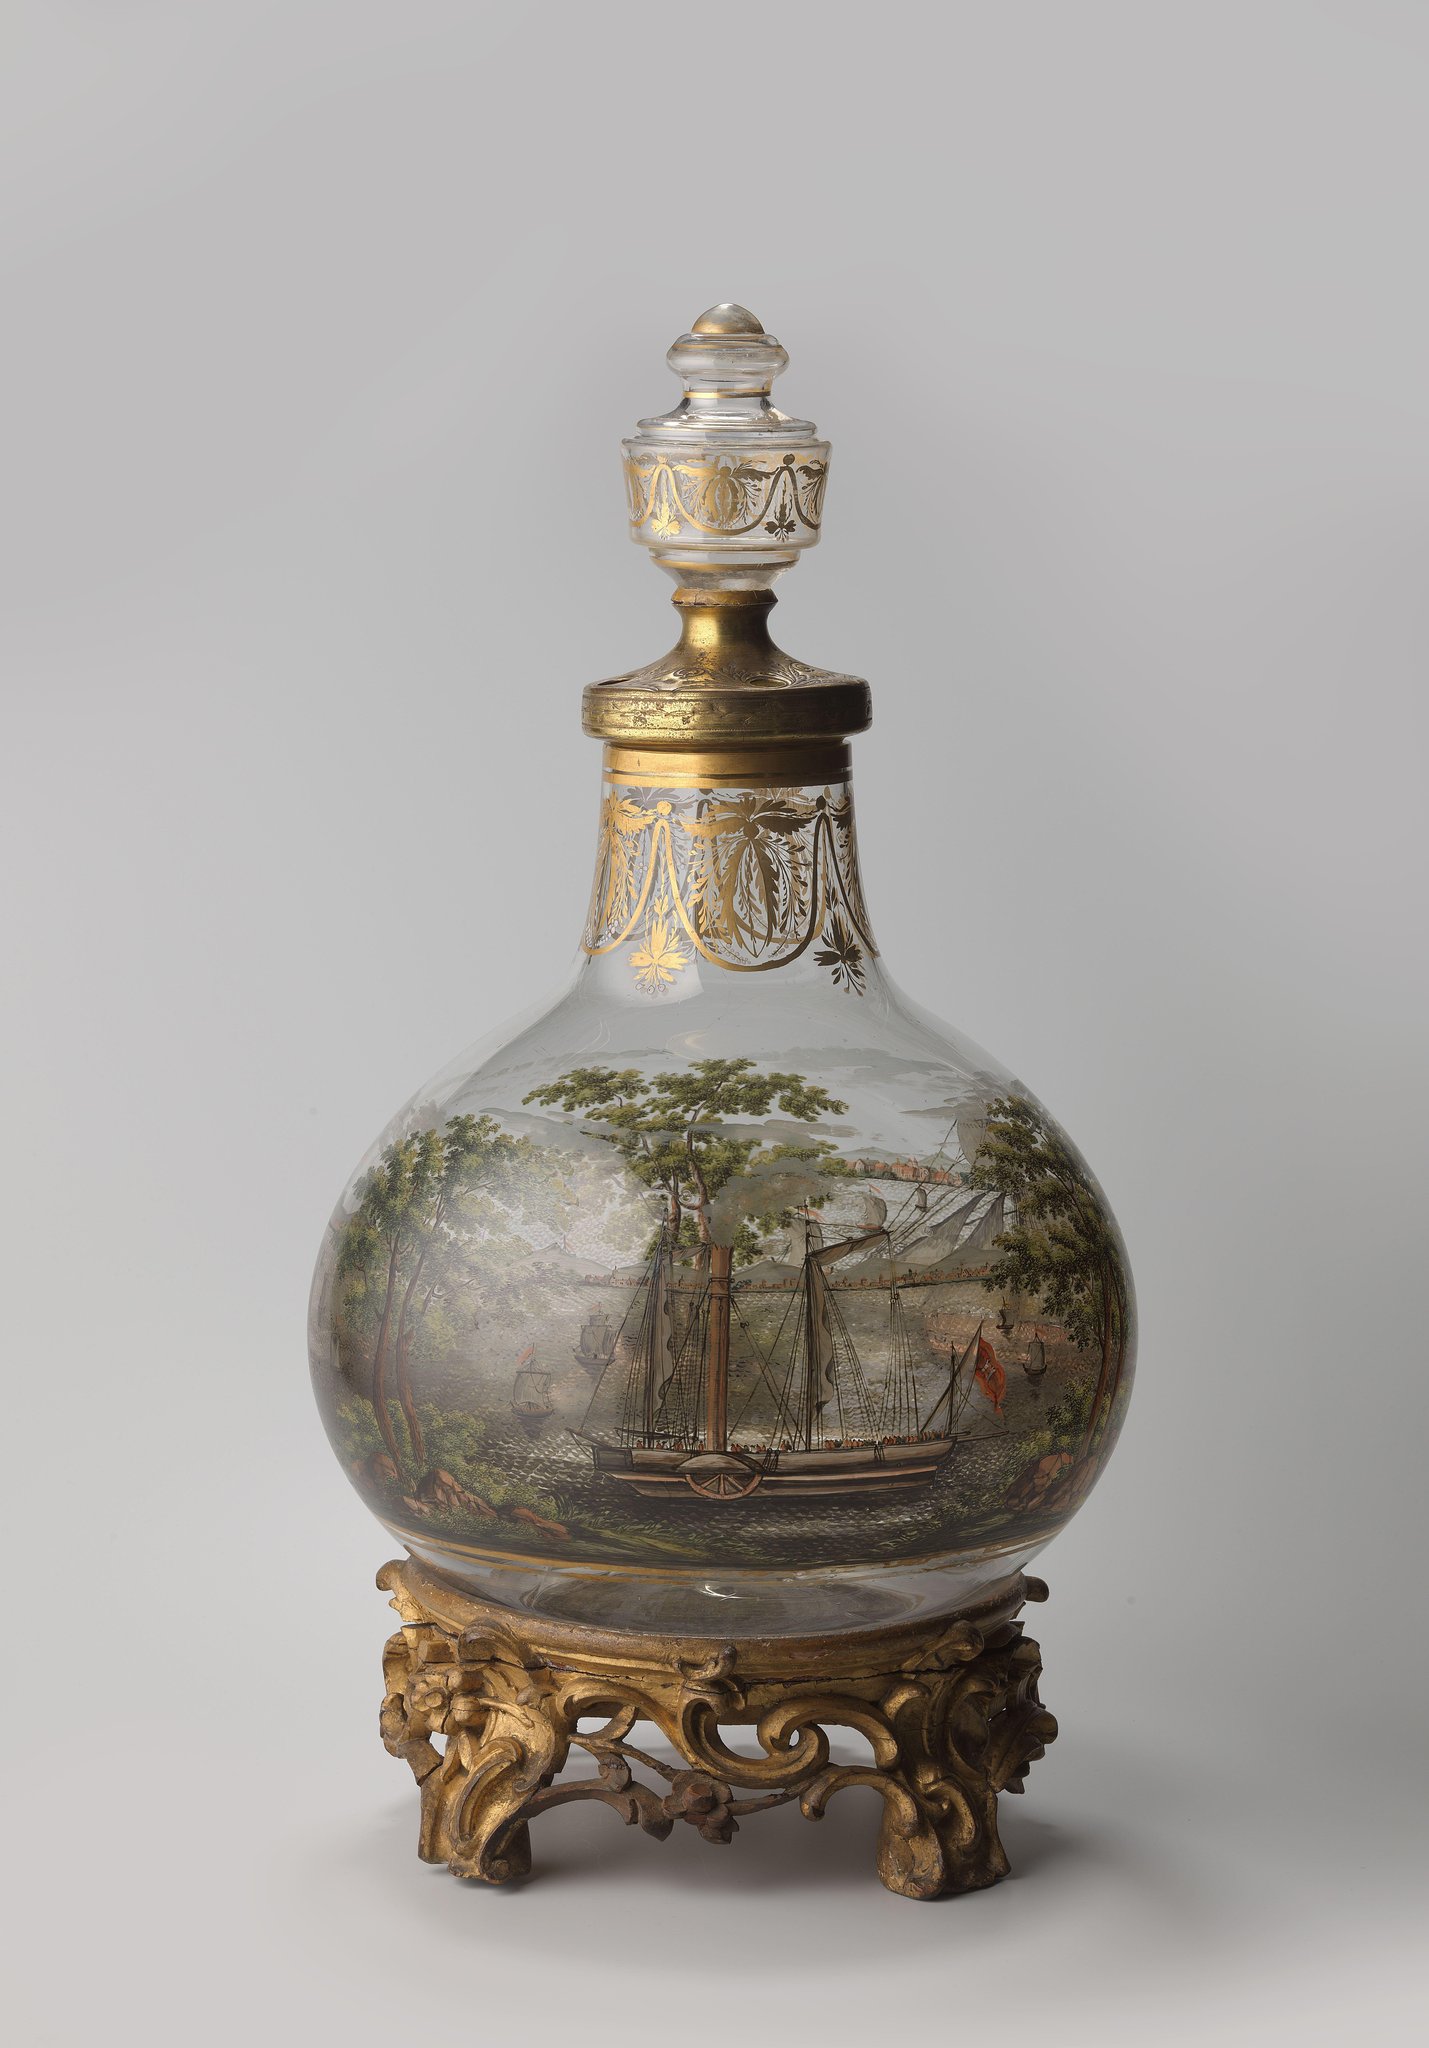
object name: goudviskom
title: Stop van goudviskom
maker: Anonymous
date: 1825-1850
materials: glass, metal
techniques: gilding, glassblowing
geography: bohemia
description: Holle, geprofileerde, balustervormige stop met een verguld metalen onderstuk en luchtgaten. Een guirlande in wit en goud.